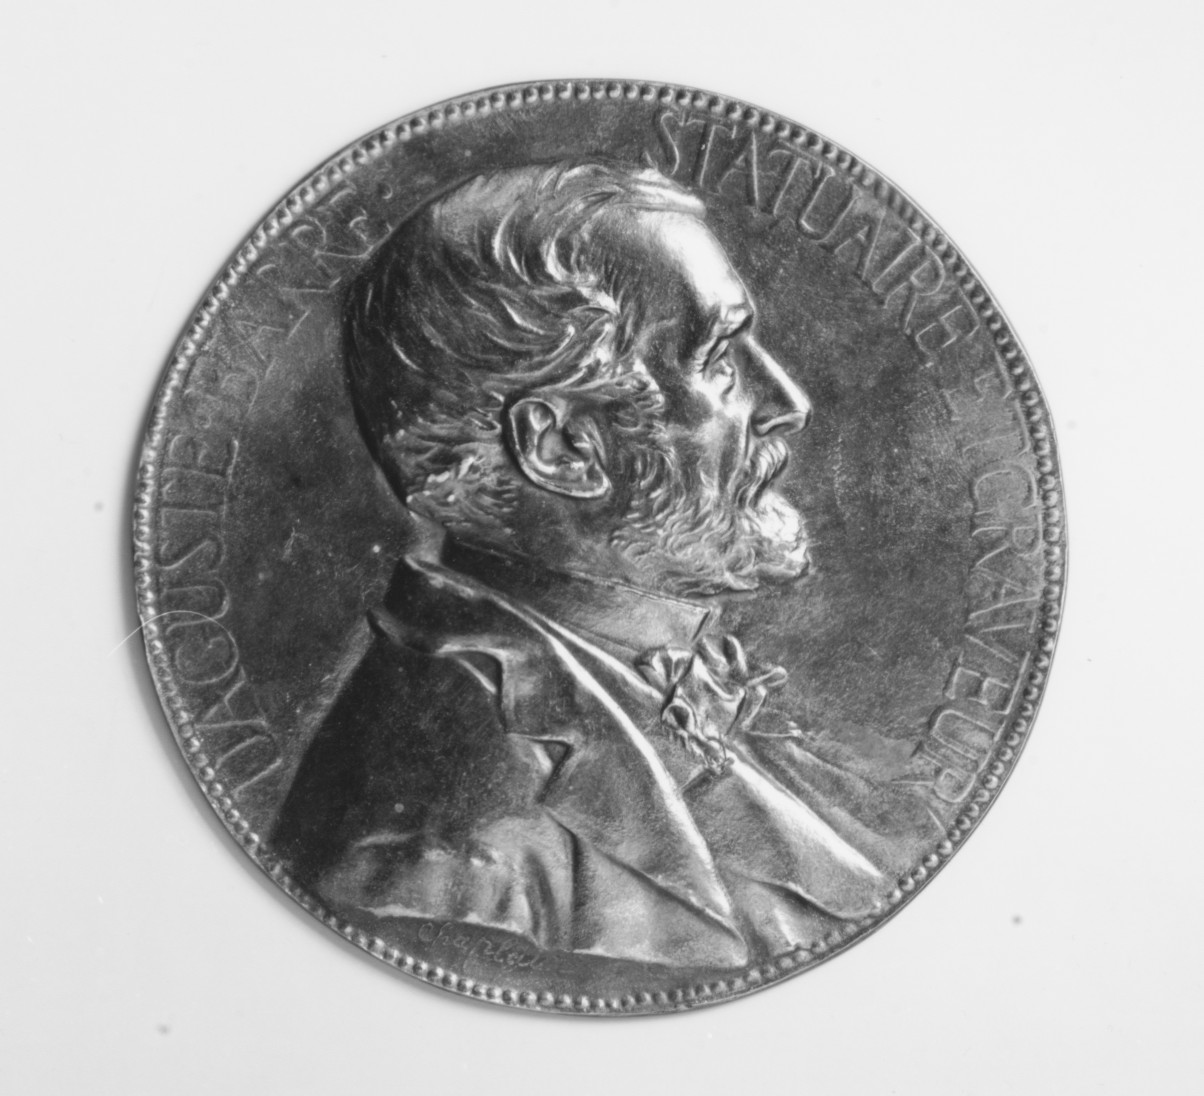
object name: medal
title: Auguste Barre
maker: jules-clément chaplain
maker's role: artist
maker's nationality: french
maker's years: 1839-1909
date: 1880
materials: bronze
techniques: silvered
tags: men,profiles